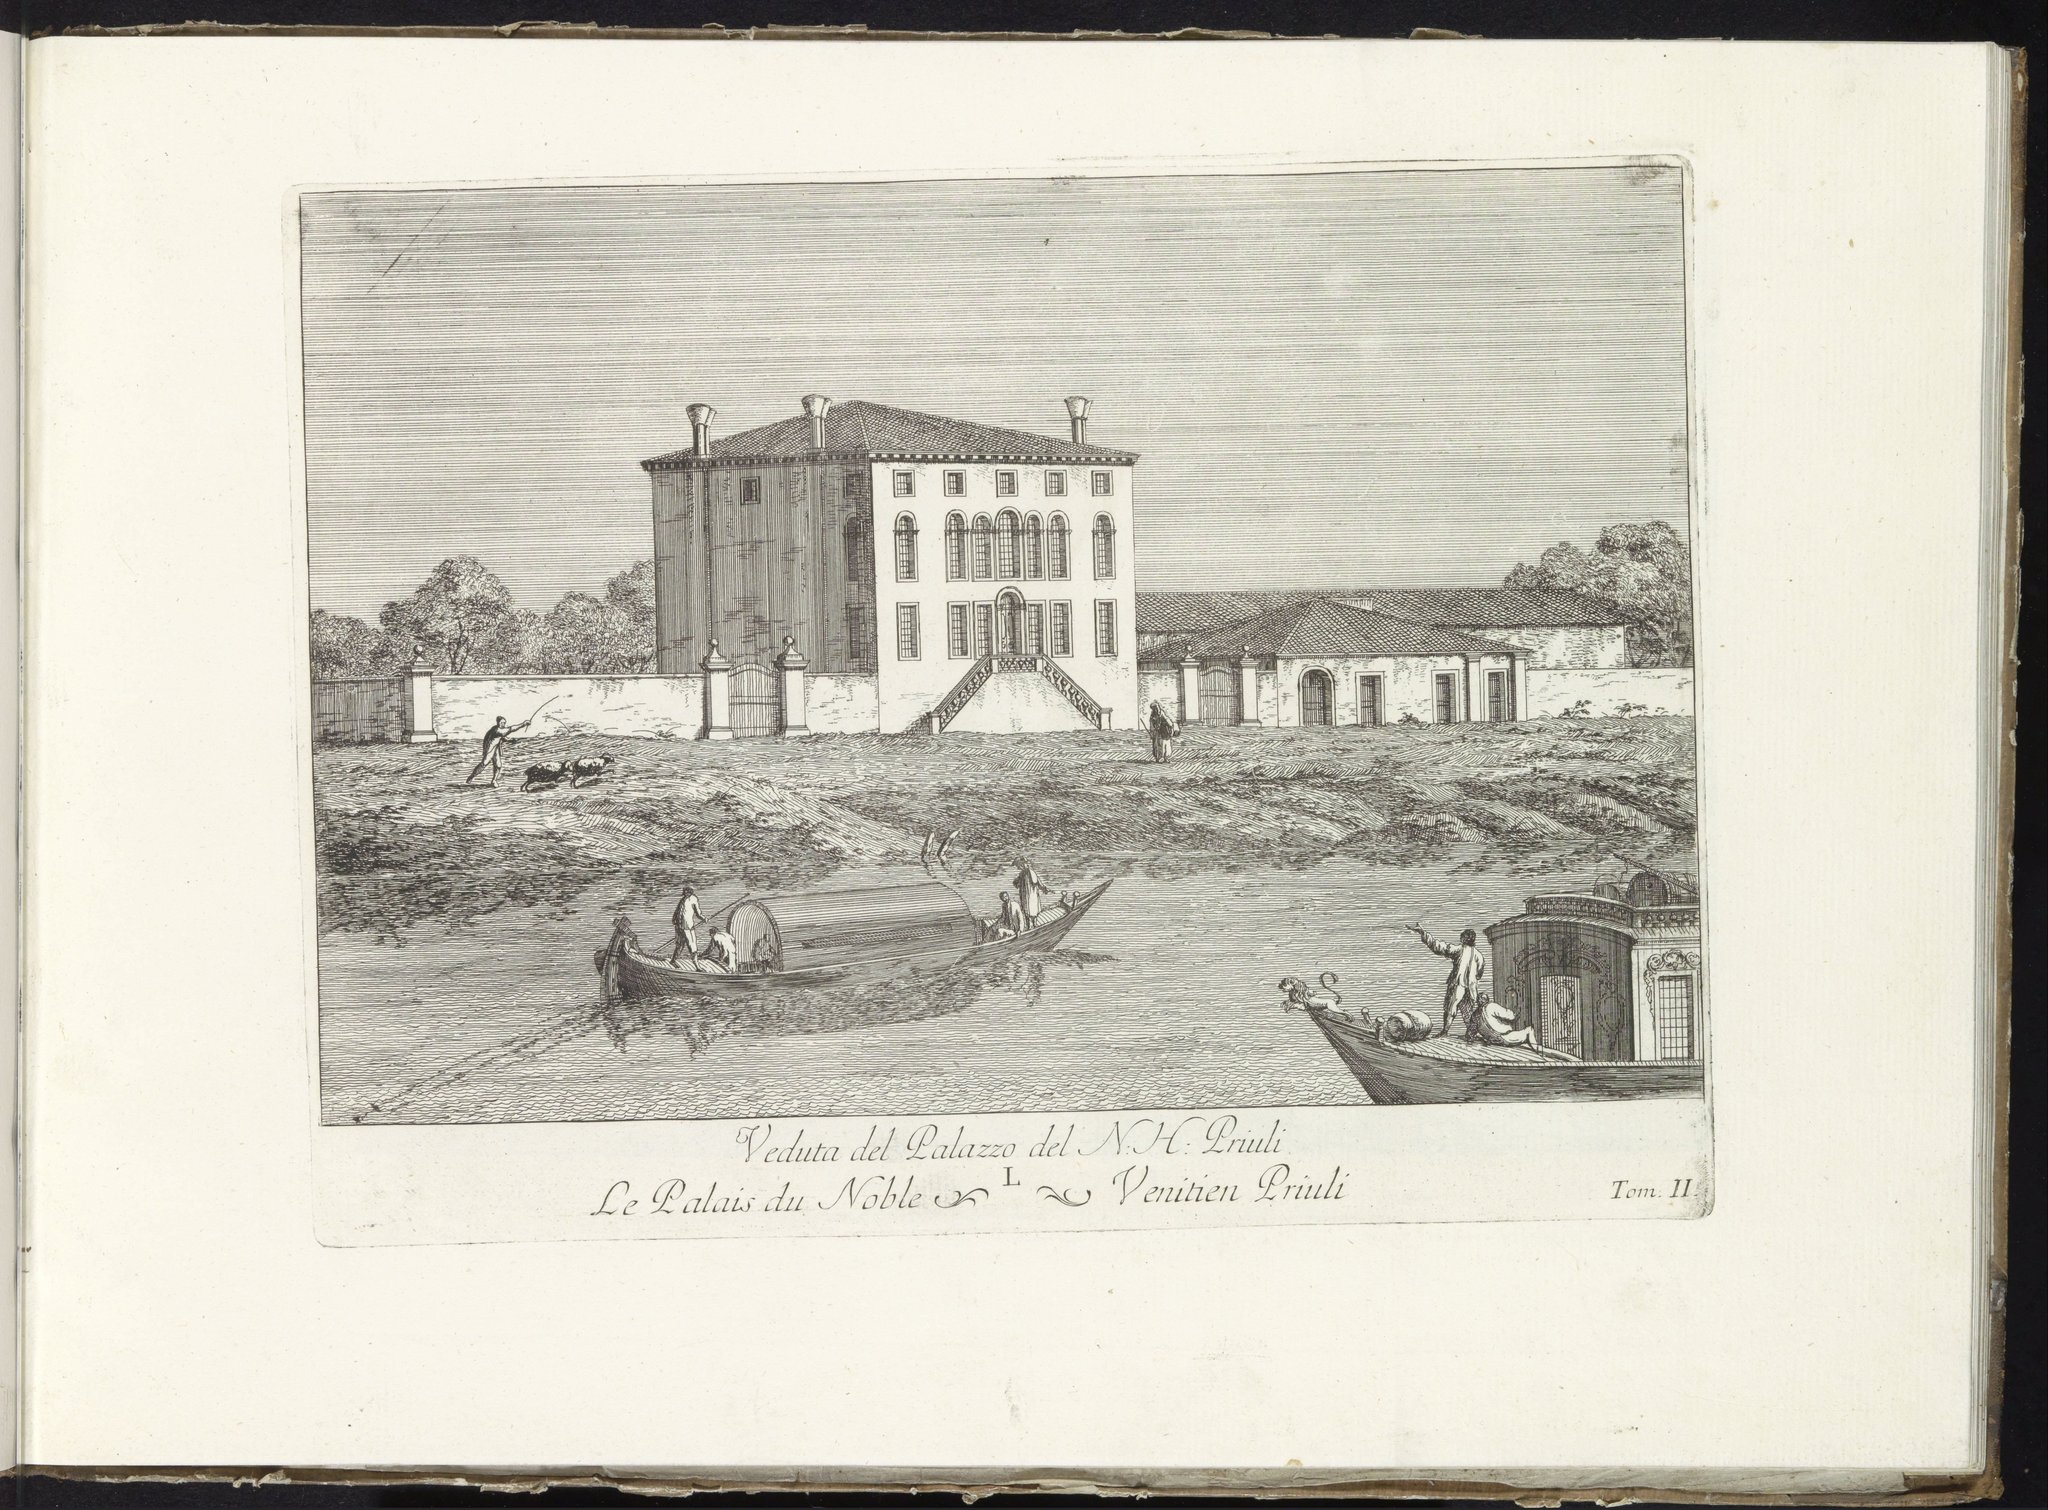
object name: print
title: Veduta del Palazzo del N: H: Priul (...)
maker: giovanni francesco costa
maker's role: draughtsman, painter, print maker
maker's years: -1773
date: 1750-1760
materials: paper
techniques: etching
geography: italy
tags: river, hôtel, i.e. small palace in city, gondola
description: Gezicht op Palazzo del N: H: Priuli aan de rivier de Brenta. Op het water vaart een gondel. Genummerd midden onder: L en rechtsonder: Tom: II. Deze prent maakt deel uit van een album.